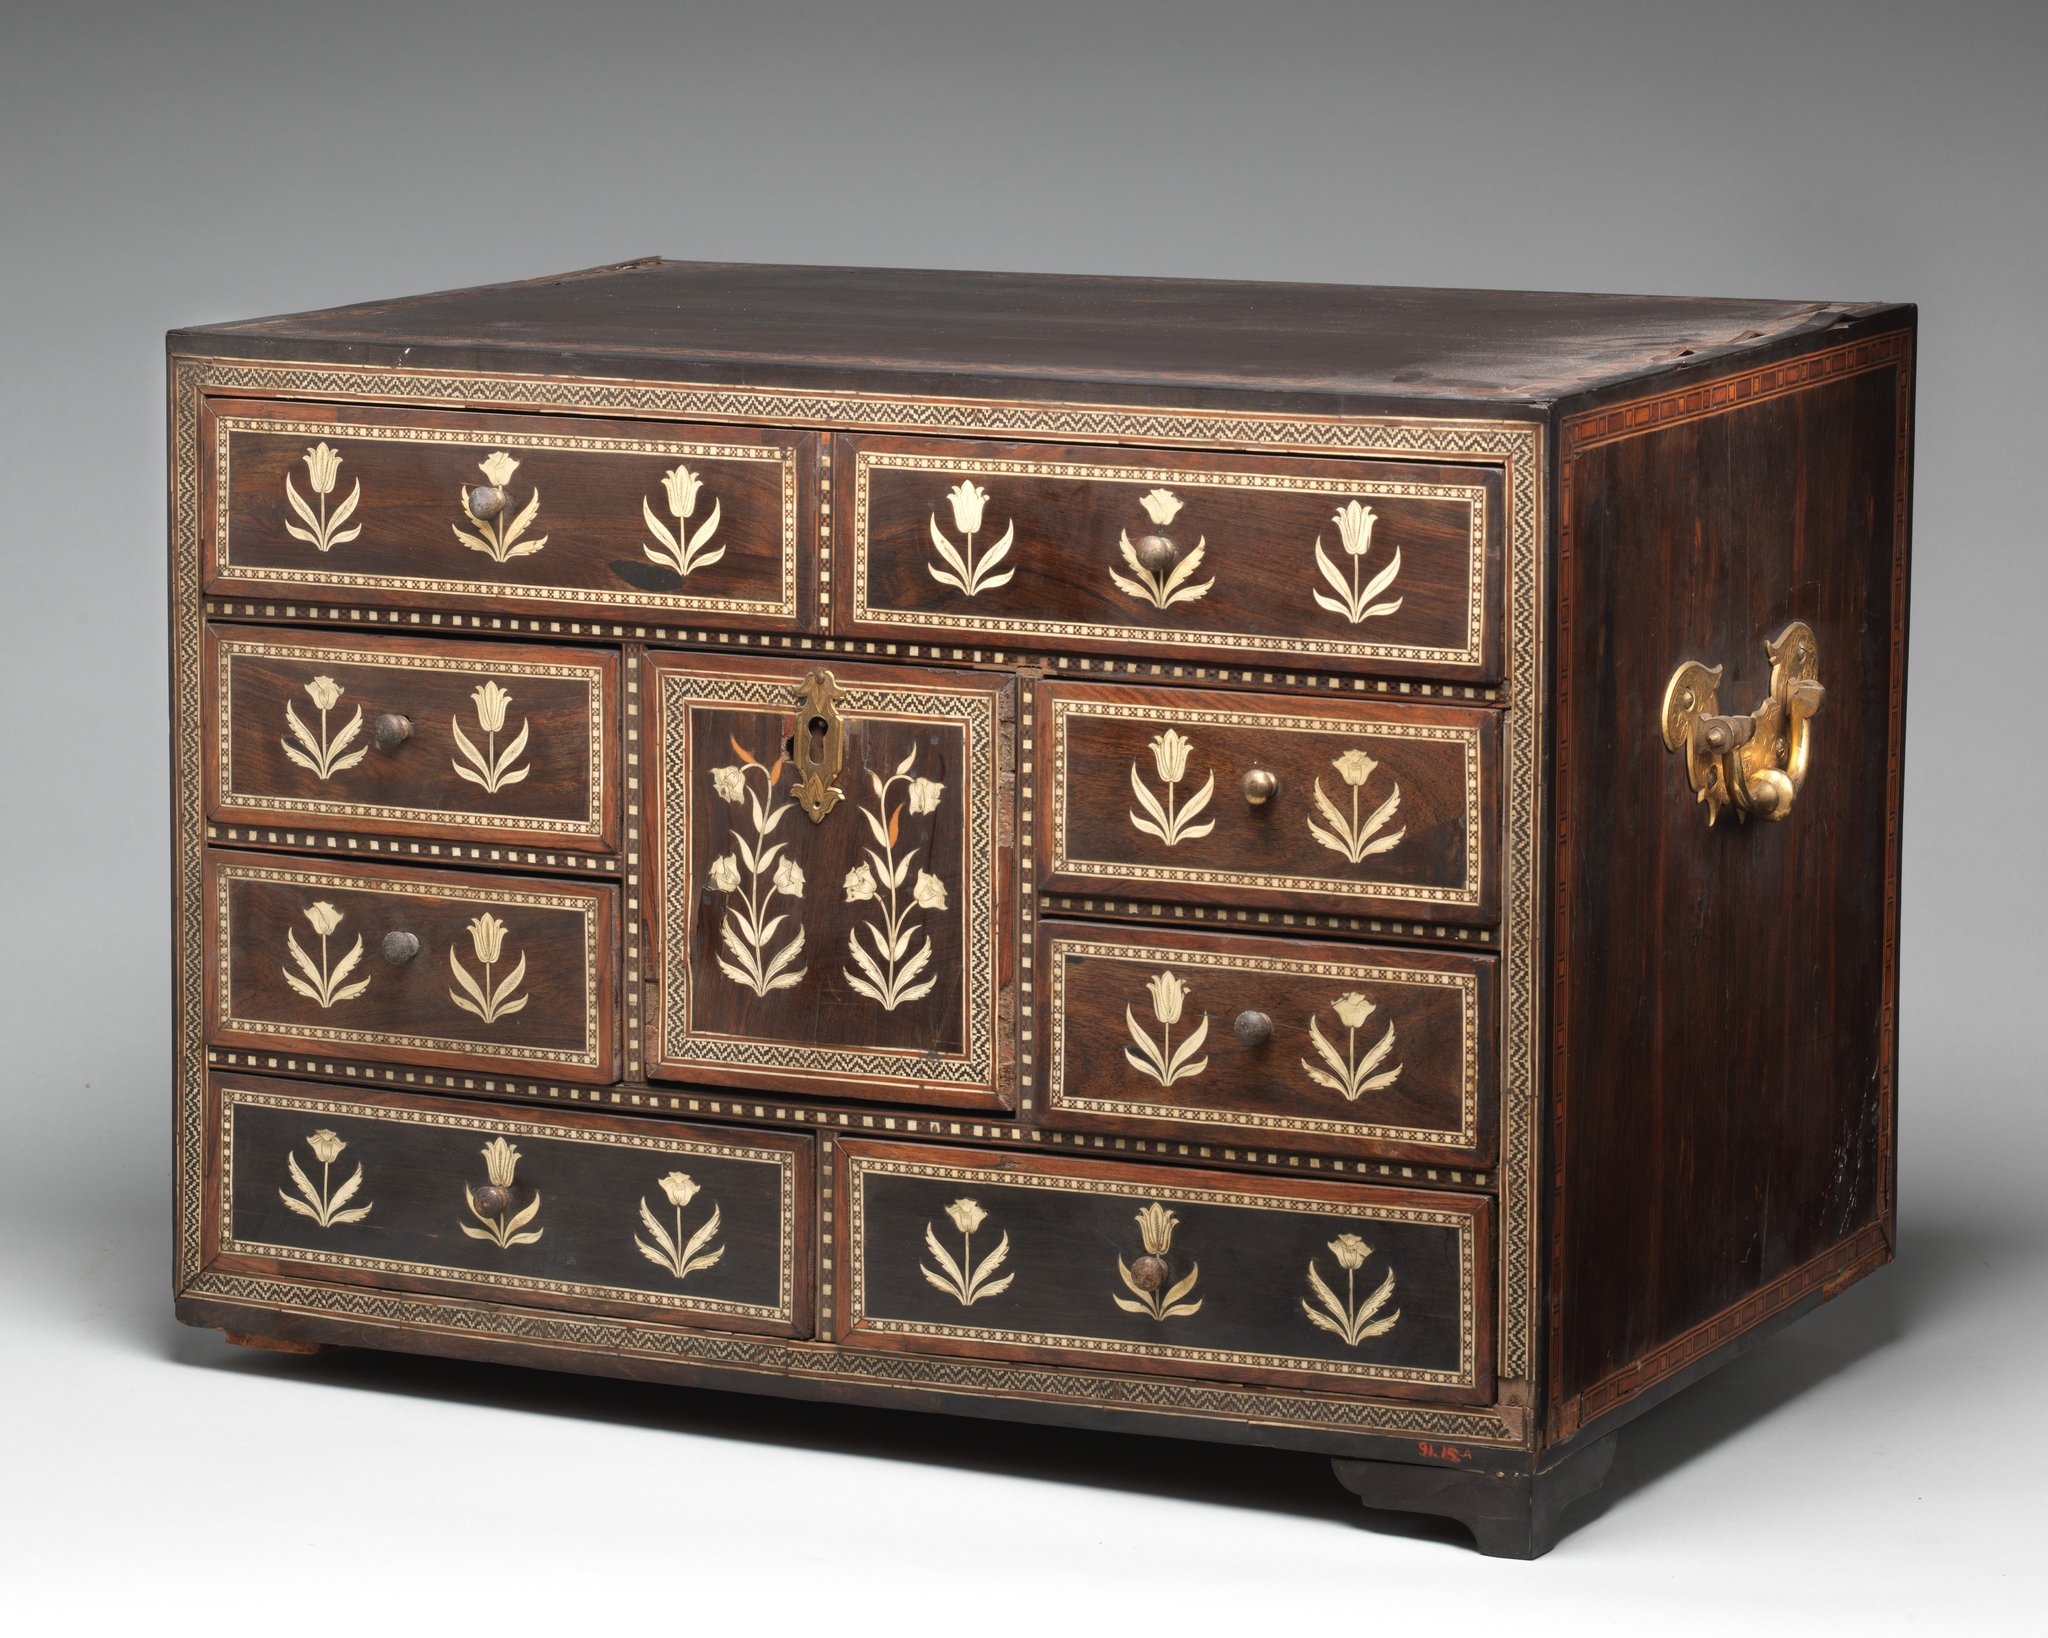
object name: cabinet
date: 1667-1733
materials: ivory, wood